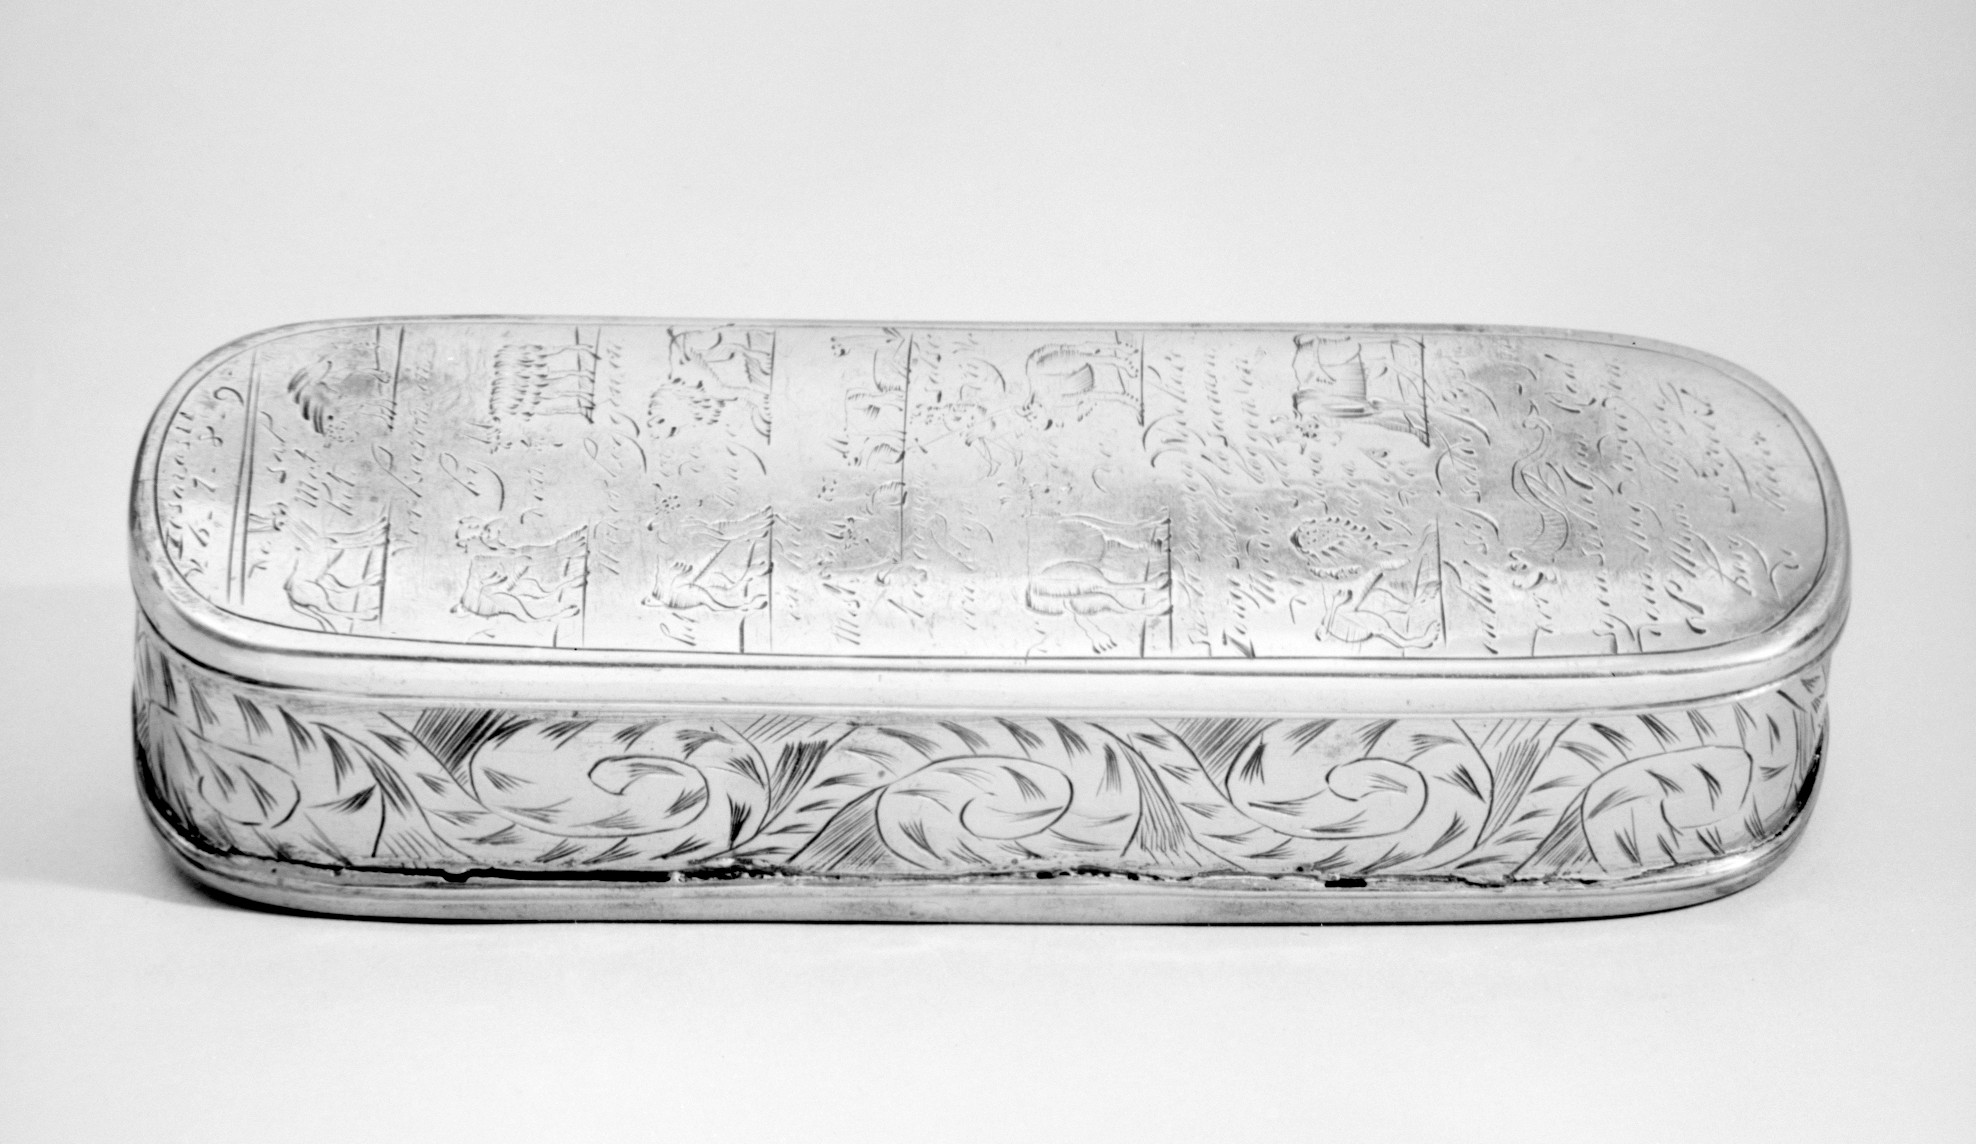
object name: tobacco box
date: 1701-1800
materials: brass, copper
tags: animals